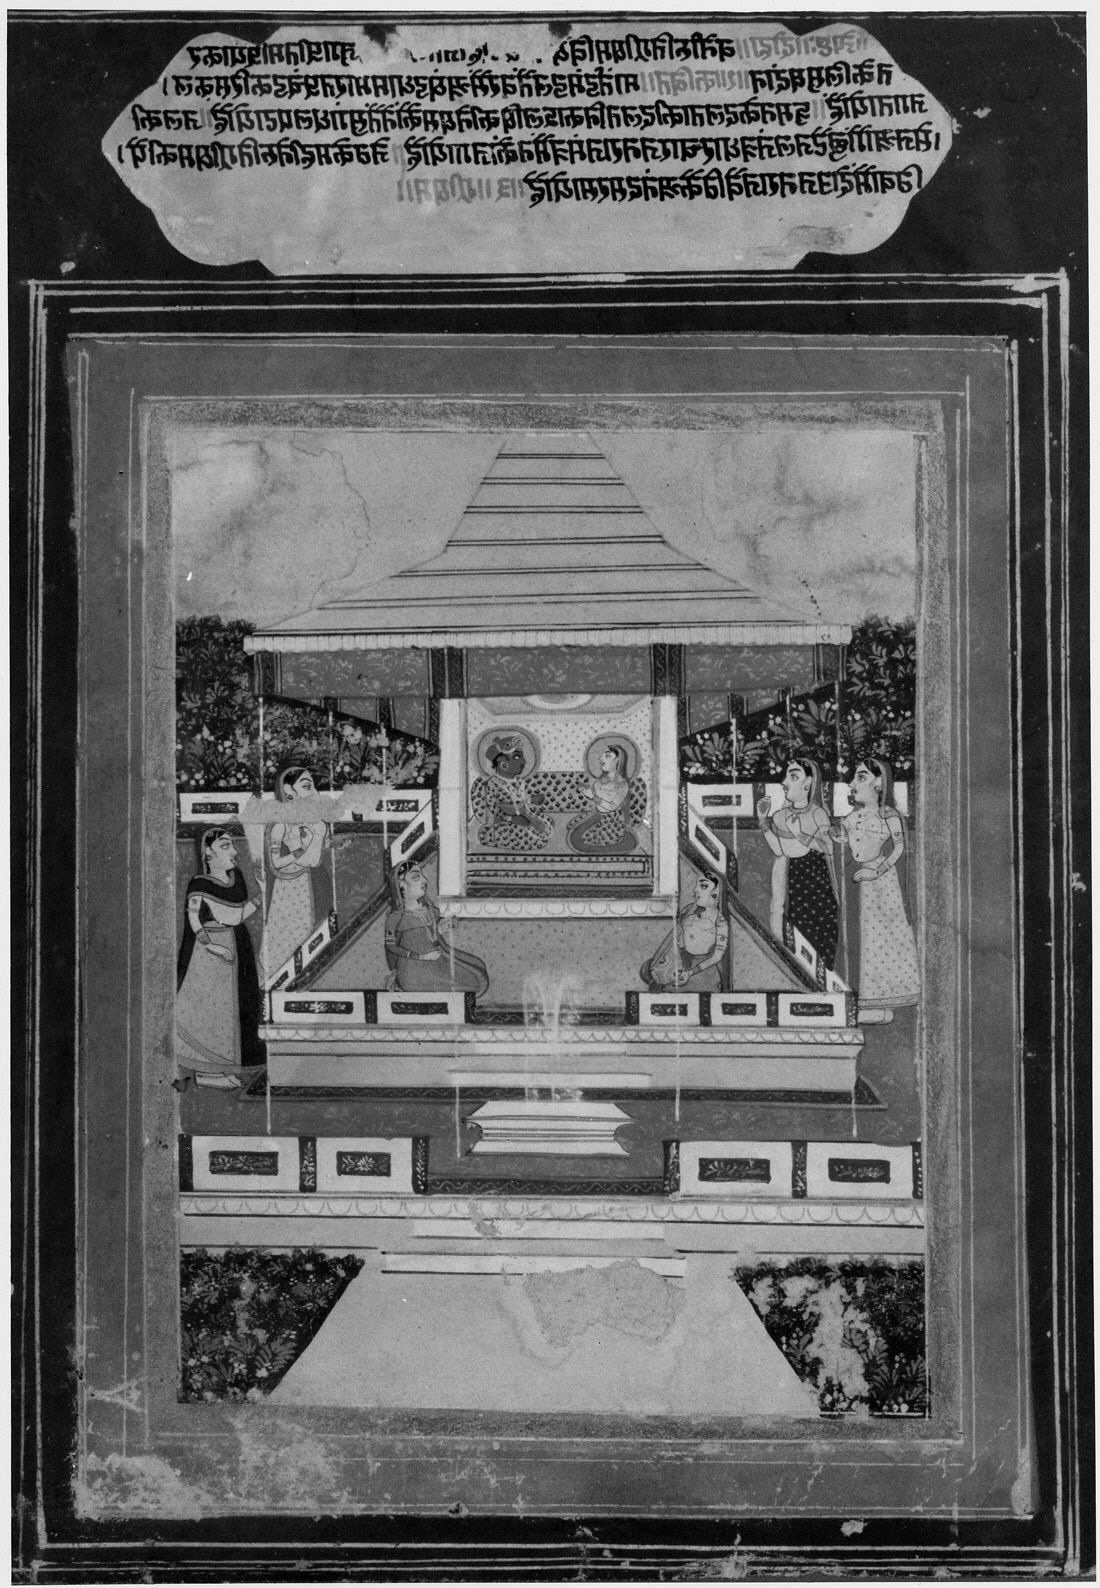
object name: painting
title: Krishna and Radha in Garden Pavilion with Female Attendants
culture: indian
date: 1867-1900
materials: gold, paper, silver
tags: women,krishna,radha,pavilions